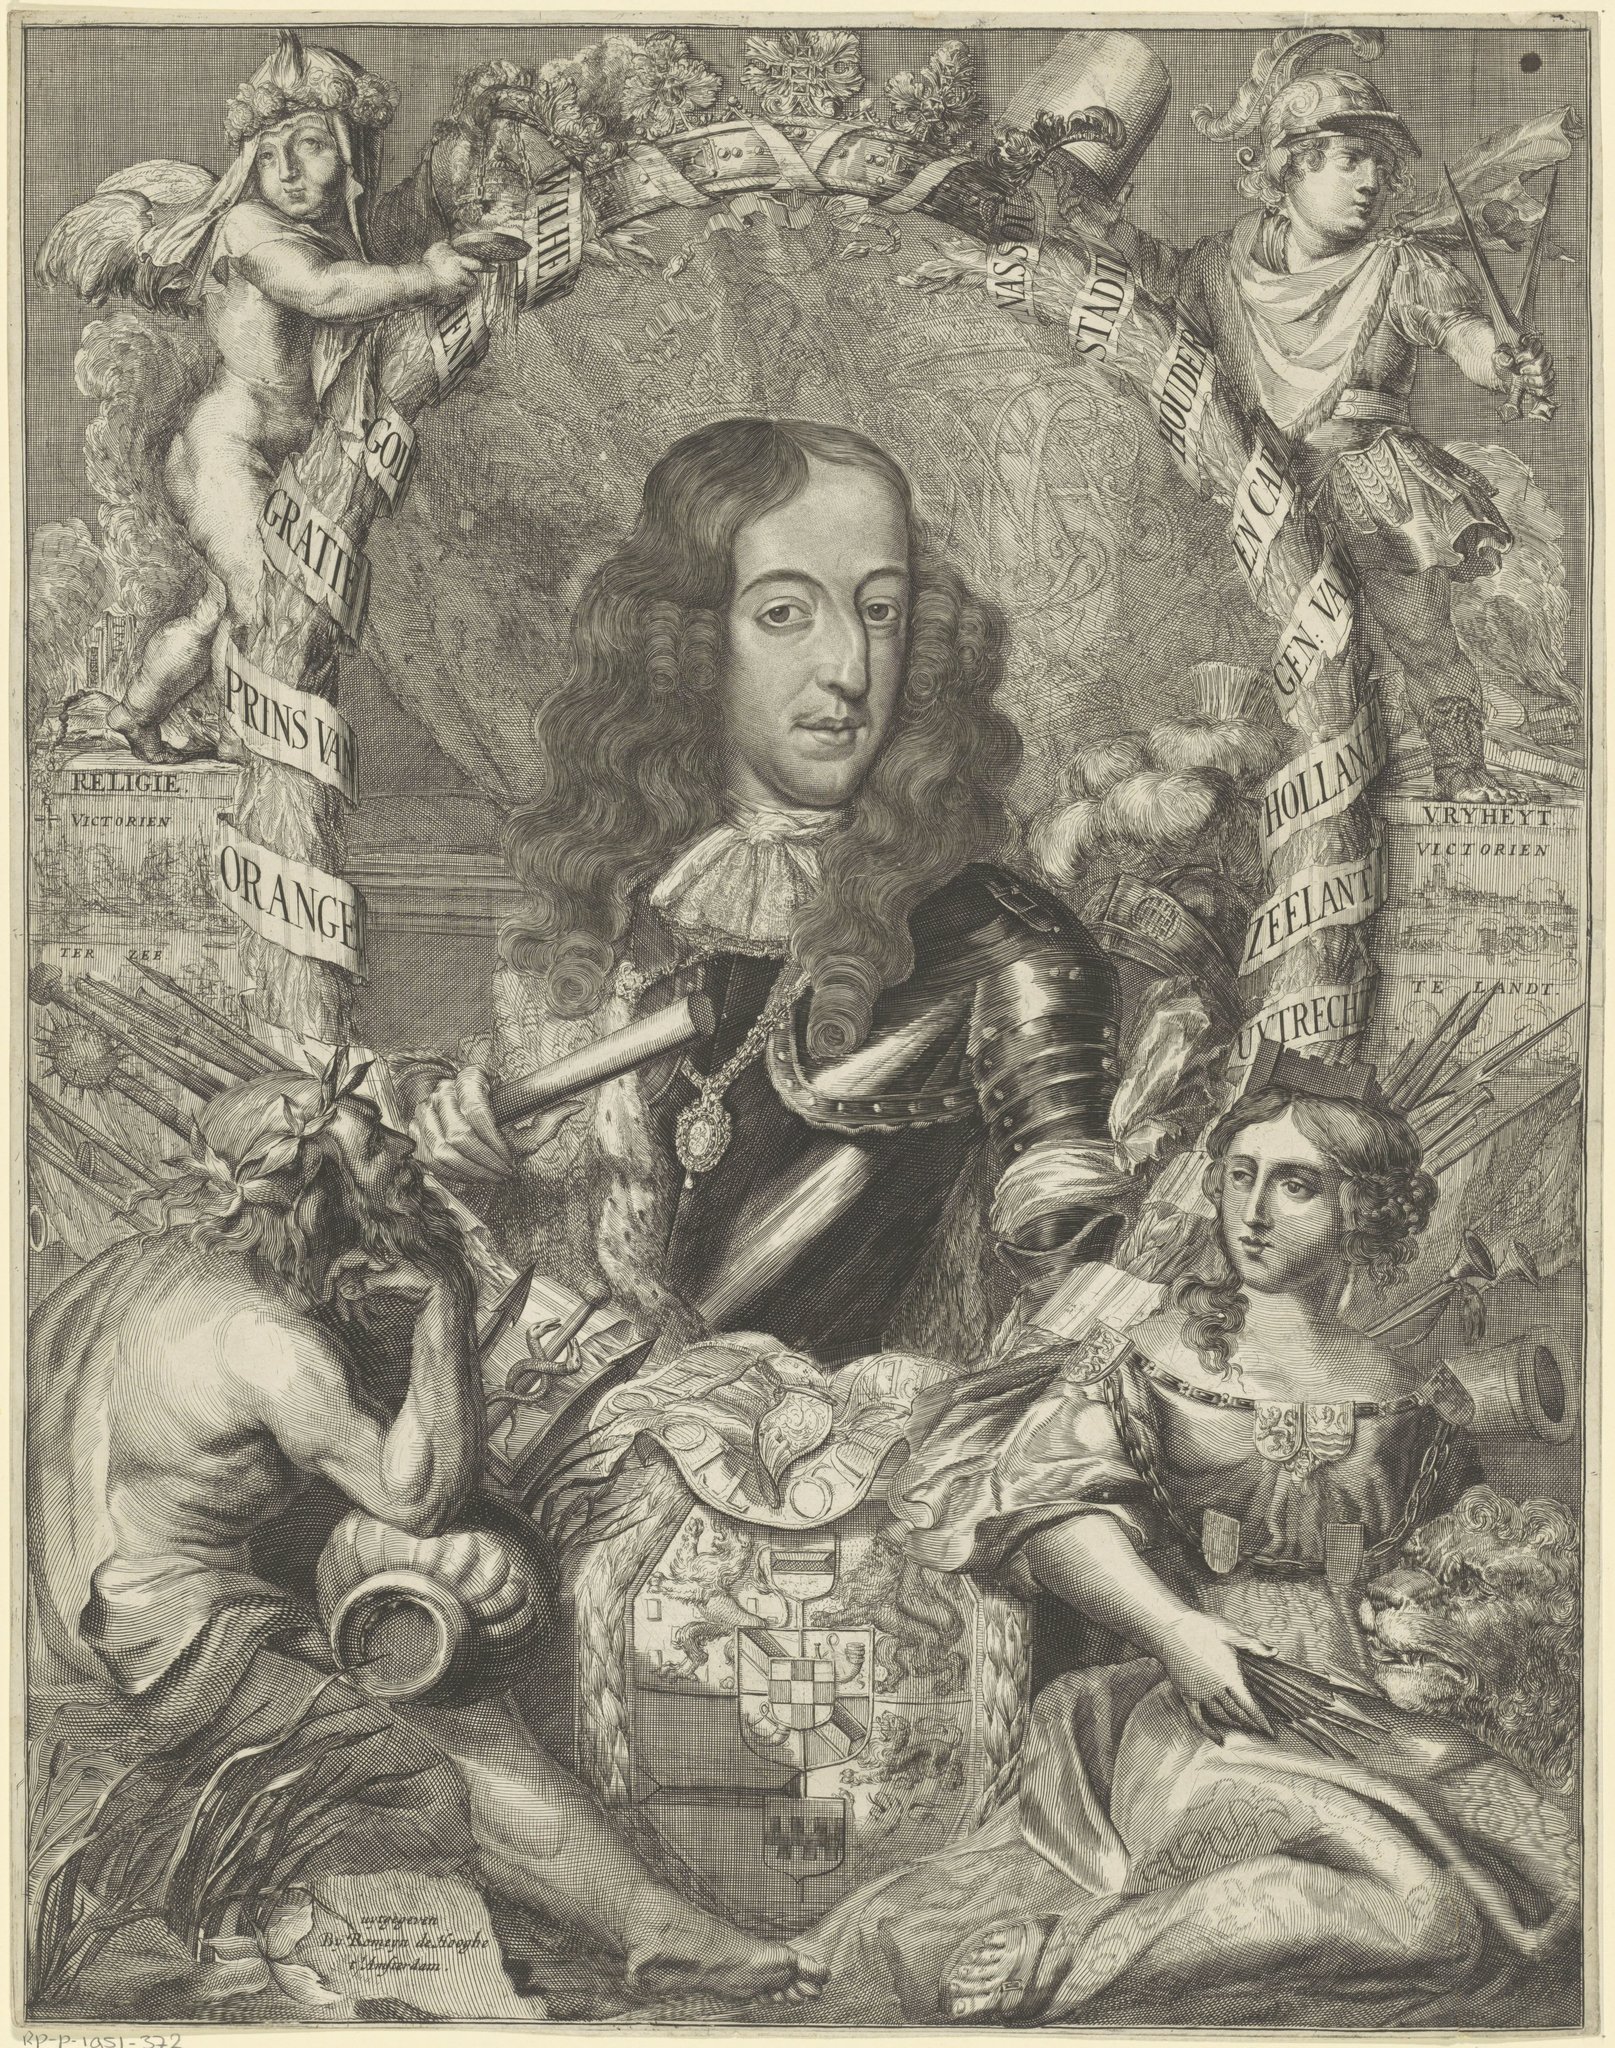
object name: print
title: Portret van Willem III, prins van Oranje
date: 1670-1708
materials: paper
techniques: engraving, etching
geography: amsterdam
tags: the hague, william iii (prince of orange and king of england, scotland, and ireland), knighthood order (garter) - insignia of a knighthood order, e.g.: badge, chain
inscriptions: collector's mark: Lugt 2228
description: Portret van Willem III in een ovaal van lauwerbladen en lint met schrift. In zijn rechterhand een commandostaf. Daar omheen een aantal allegorische objecten en figuren, waaronder de Nederlandse Maagd, Religie en Vrijheid. Midden onder zijn wapen, gedecoreerd met de Kousenband en het devies van de Orde van de Kousenband.